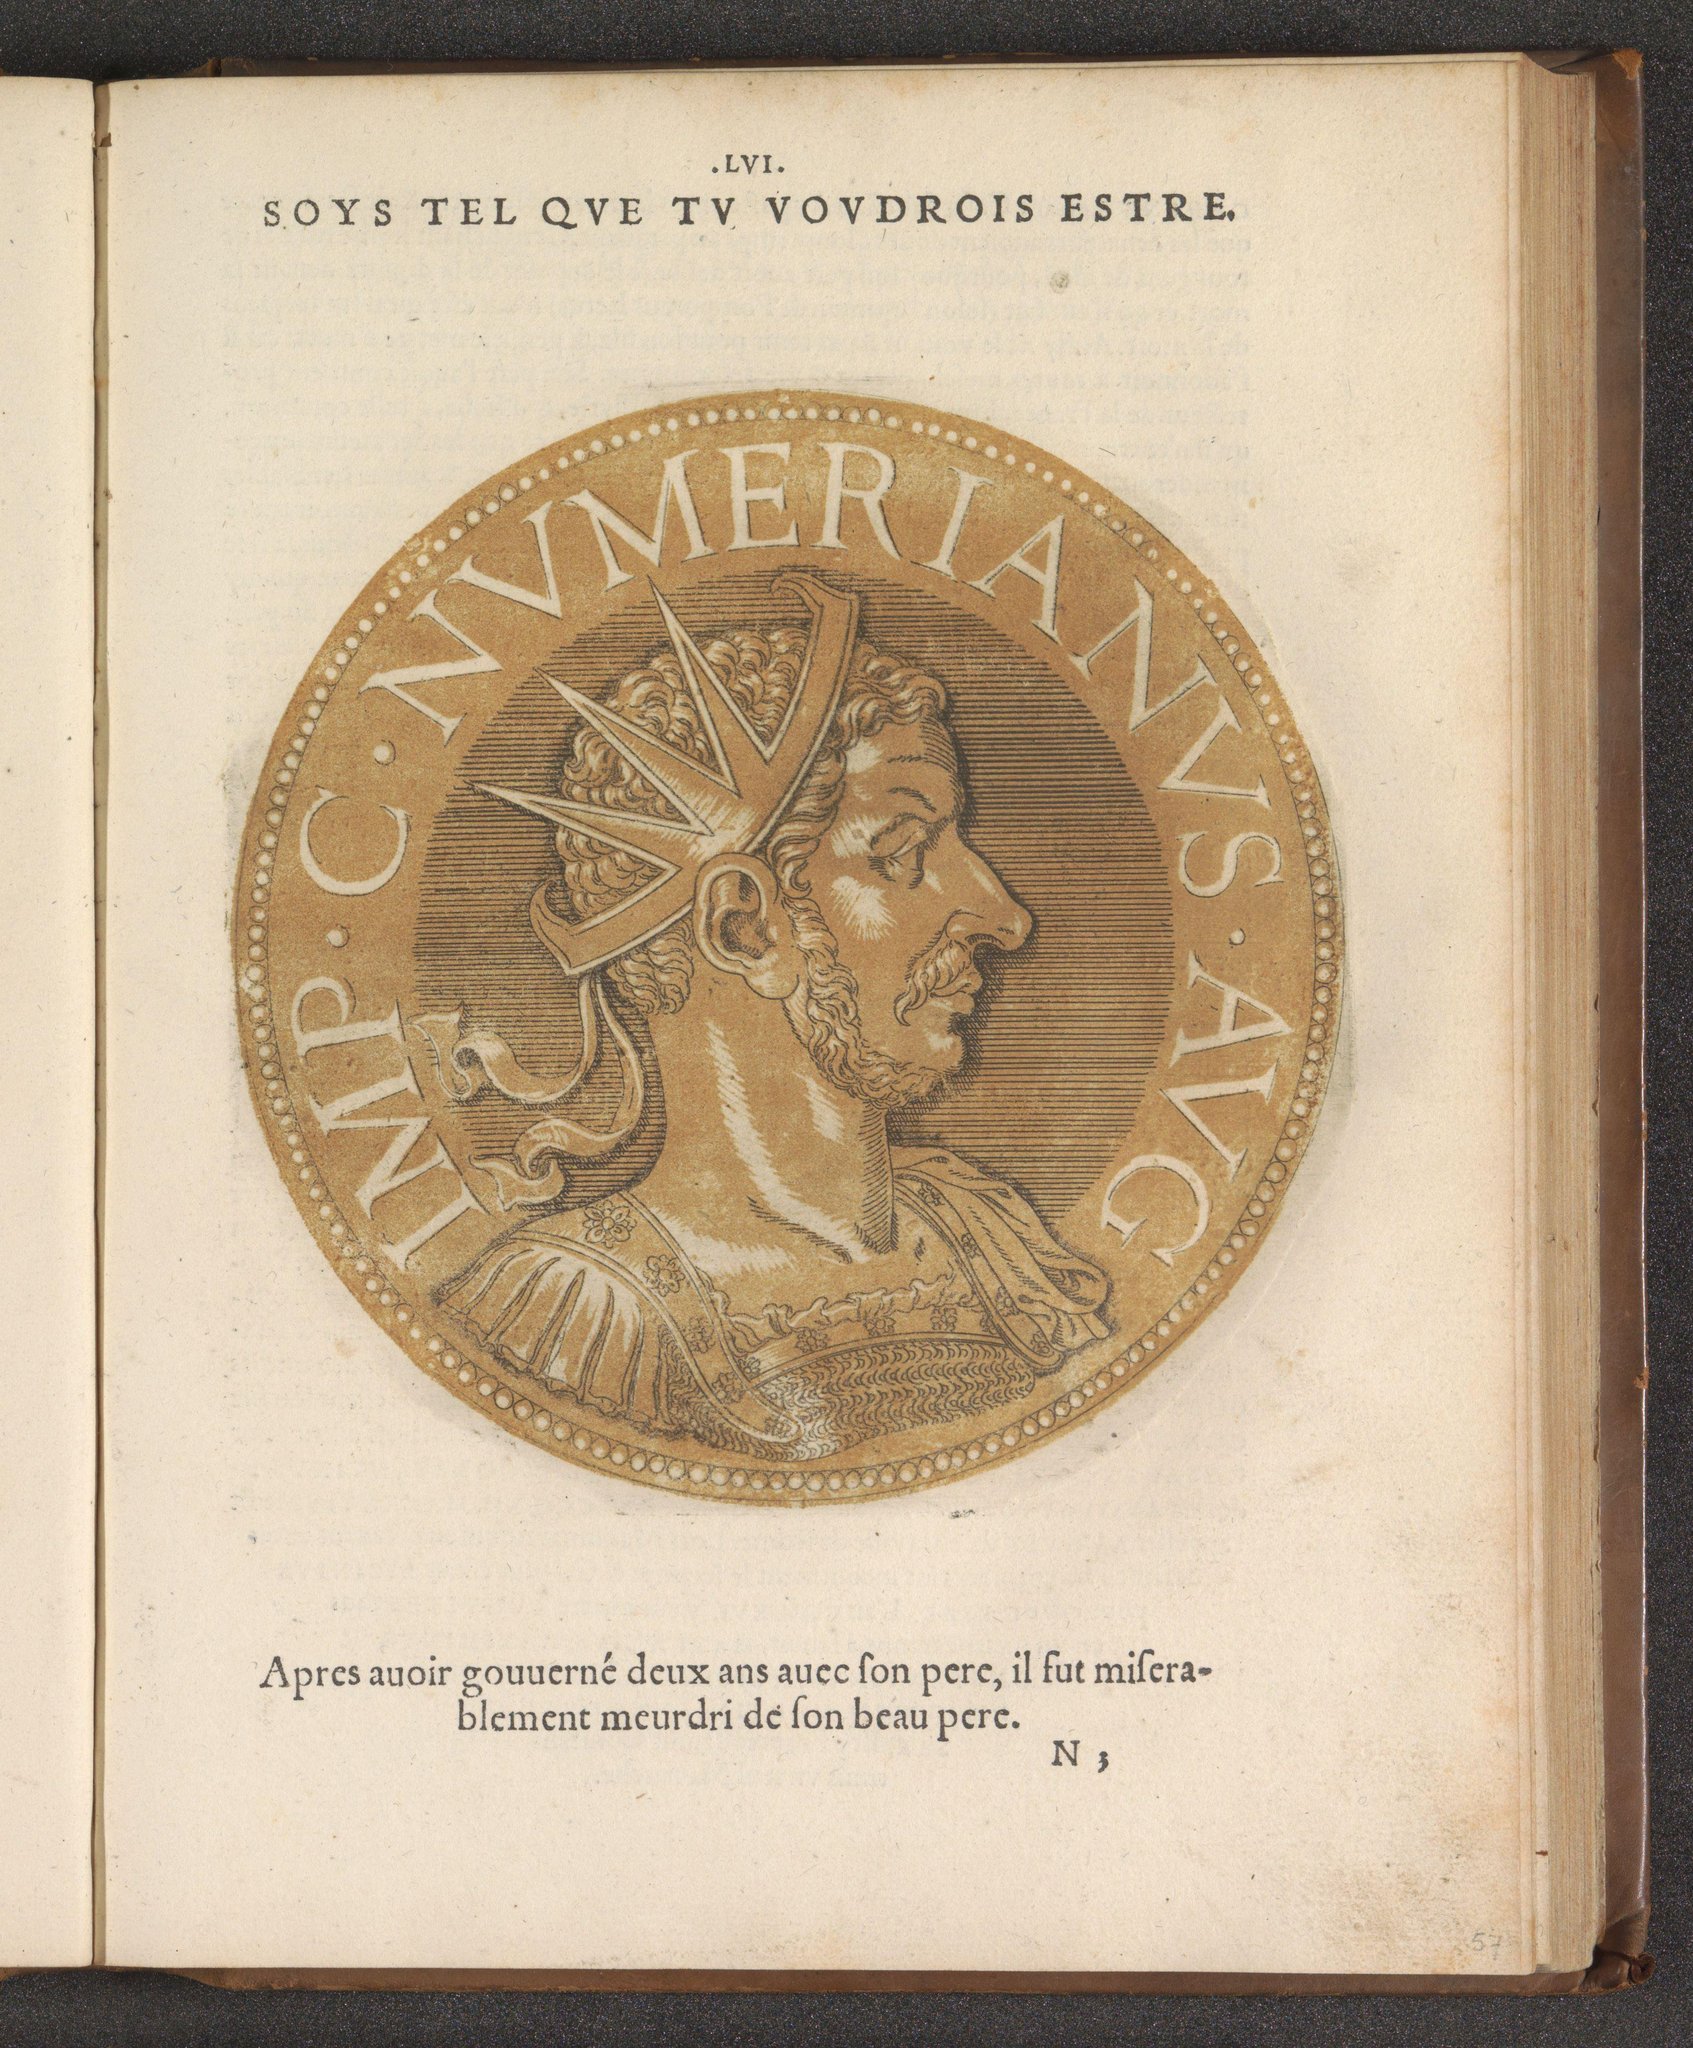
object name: print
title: Les images presque de tous les empereurs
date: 1557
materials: paper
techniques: woodcut, etching, letterpress printing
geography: antwerp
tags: emperor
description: Portret van keizer Numerianus, op een munt met randschrift. De prent maakt deel uit van een boek over de keizers vanaf Julius Caesar tot en met Karel V en zijn broer Ferdinand.